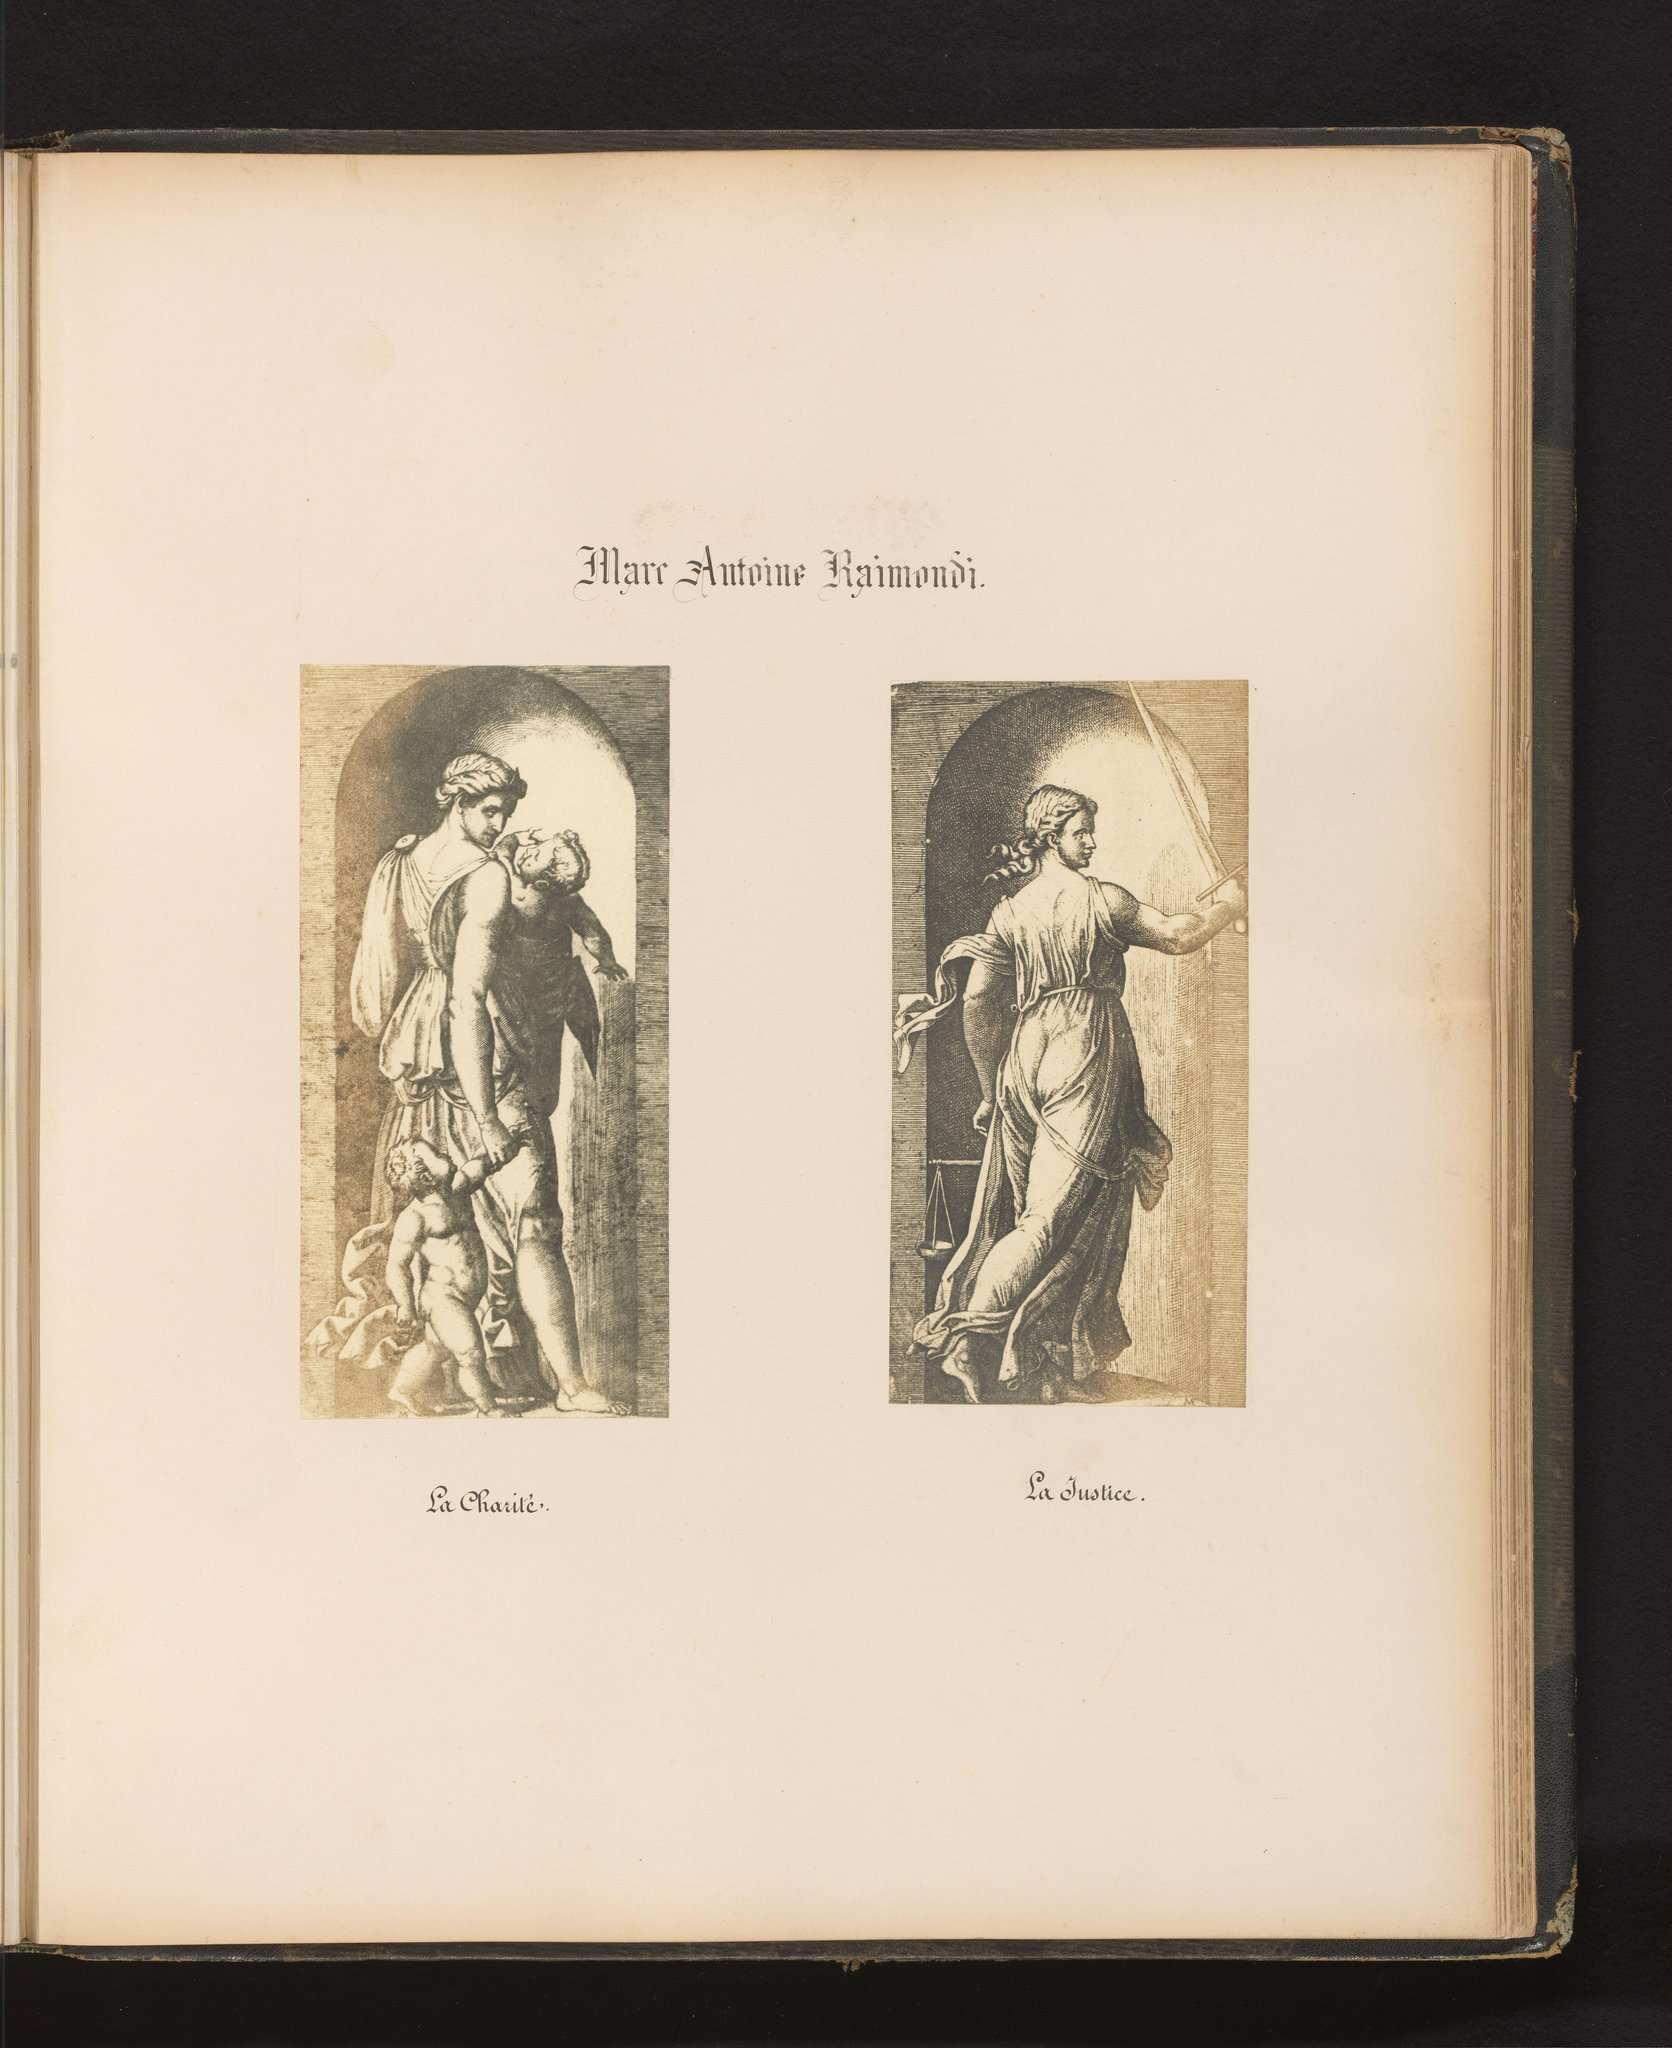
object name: reproduction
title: Marc Antoine Raimondi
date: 1848-1853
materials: photographic support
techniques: salted paper print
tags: charity, 'caritas'; 'carità' (ripa) ~ one of the three theological virtues